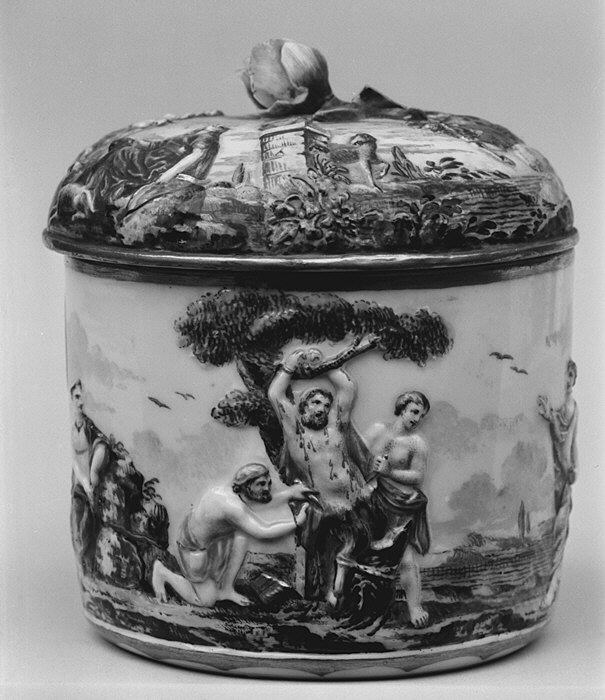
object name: sugar bowl with cover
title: Sugar bowl with cover (part of a service)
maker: doccia porcelain manufactory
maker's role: manufactory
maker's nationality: italian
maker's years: 1737-1896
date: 1760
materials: hard paste porcelain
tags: suffering,men,trees